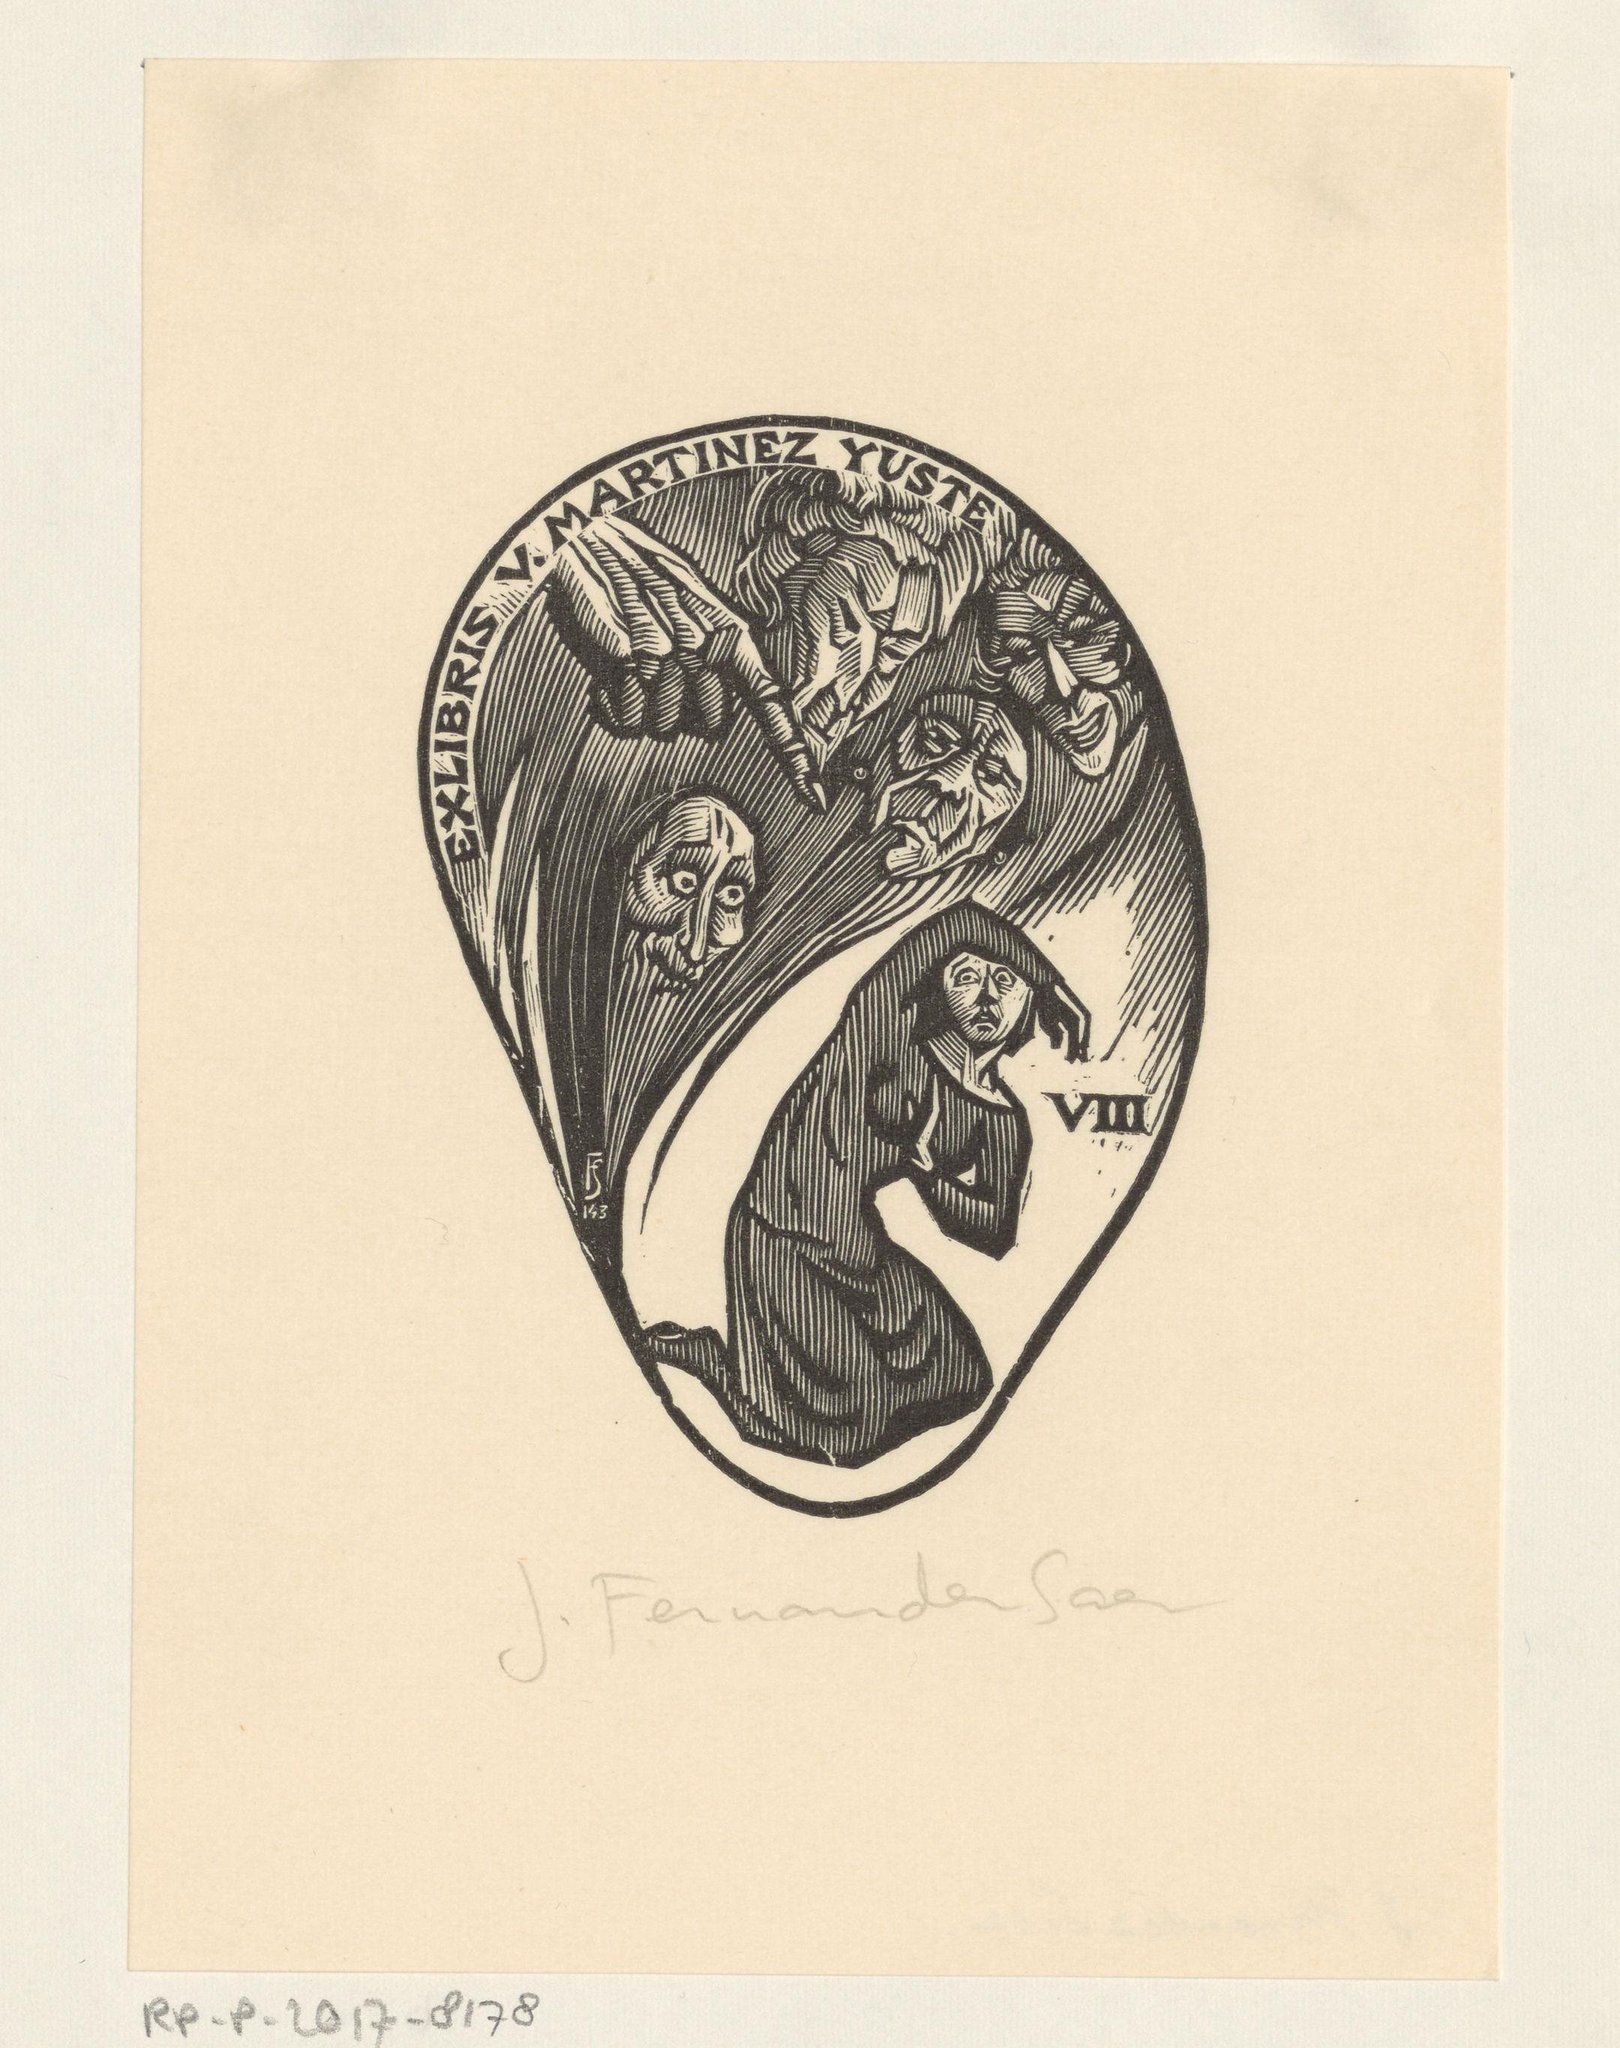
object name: bookplate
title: Ex libris van Vincente Martinez Yuste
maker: julio fernandez saez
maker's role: print maker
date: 1900-1999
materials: paper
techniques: woodcut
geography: spain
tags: fear, dread; 'paura', 'timidità o timore', 'timore' (ripa), spirit, ghost, kneeling figure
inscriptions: signature: ‘J. Fernandez Saez’